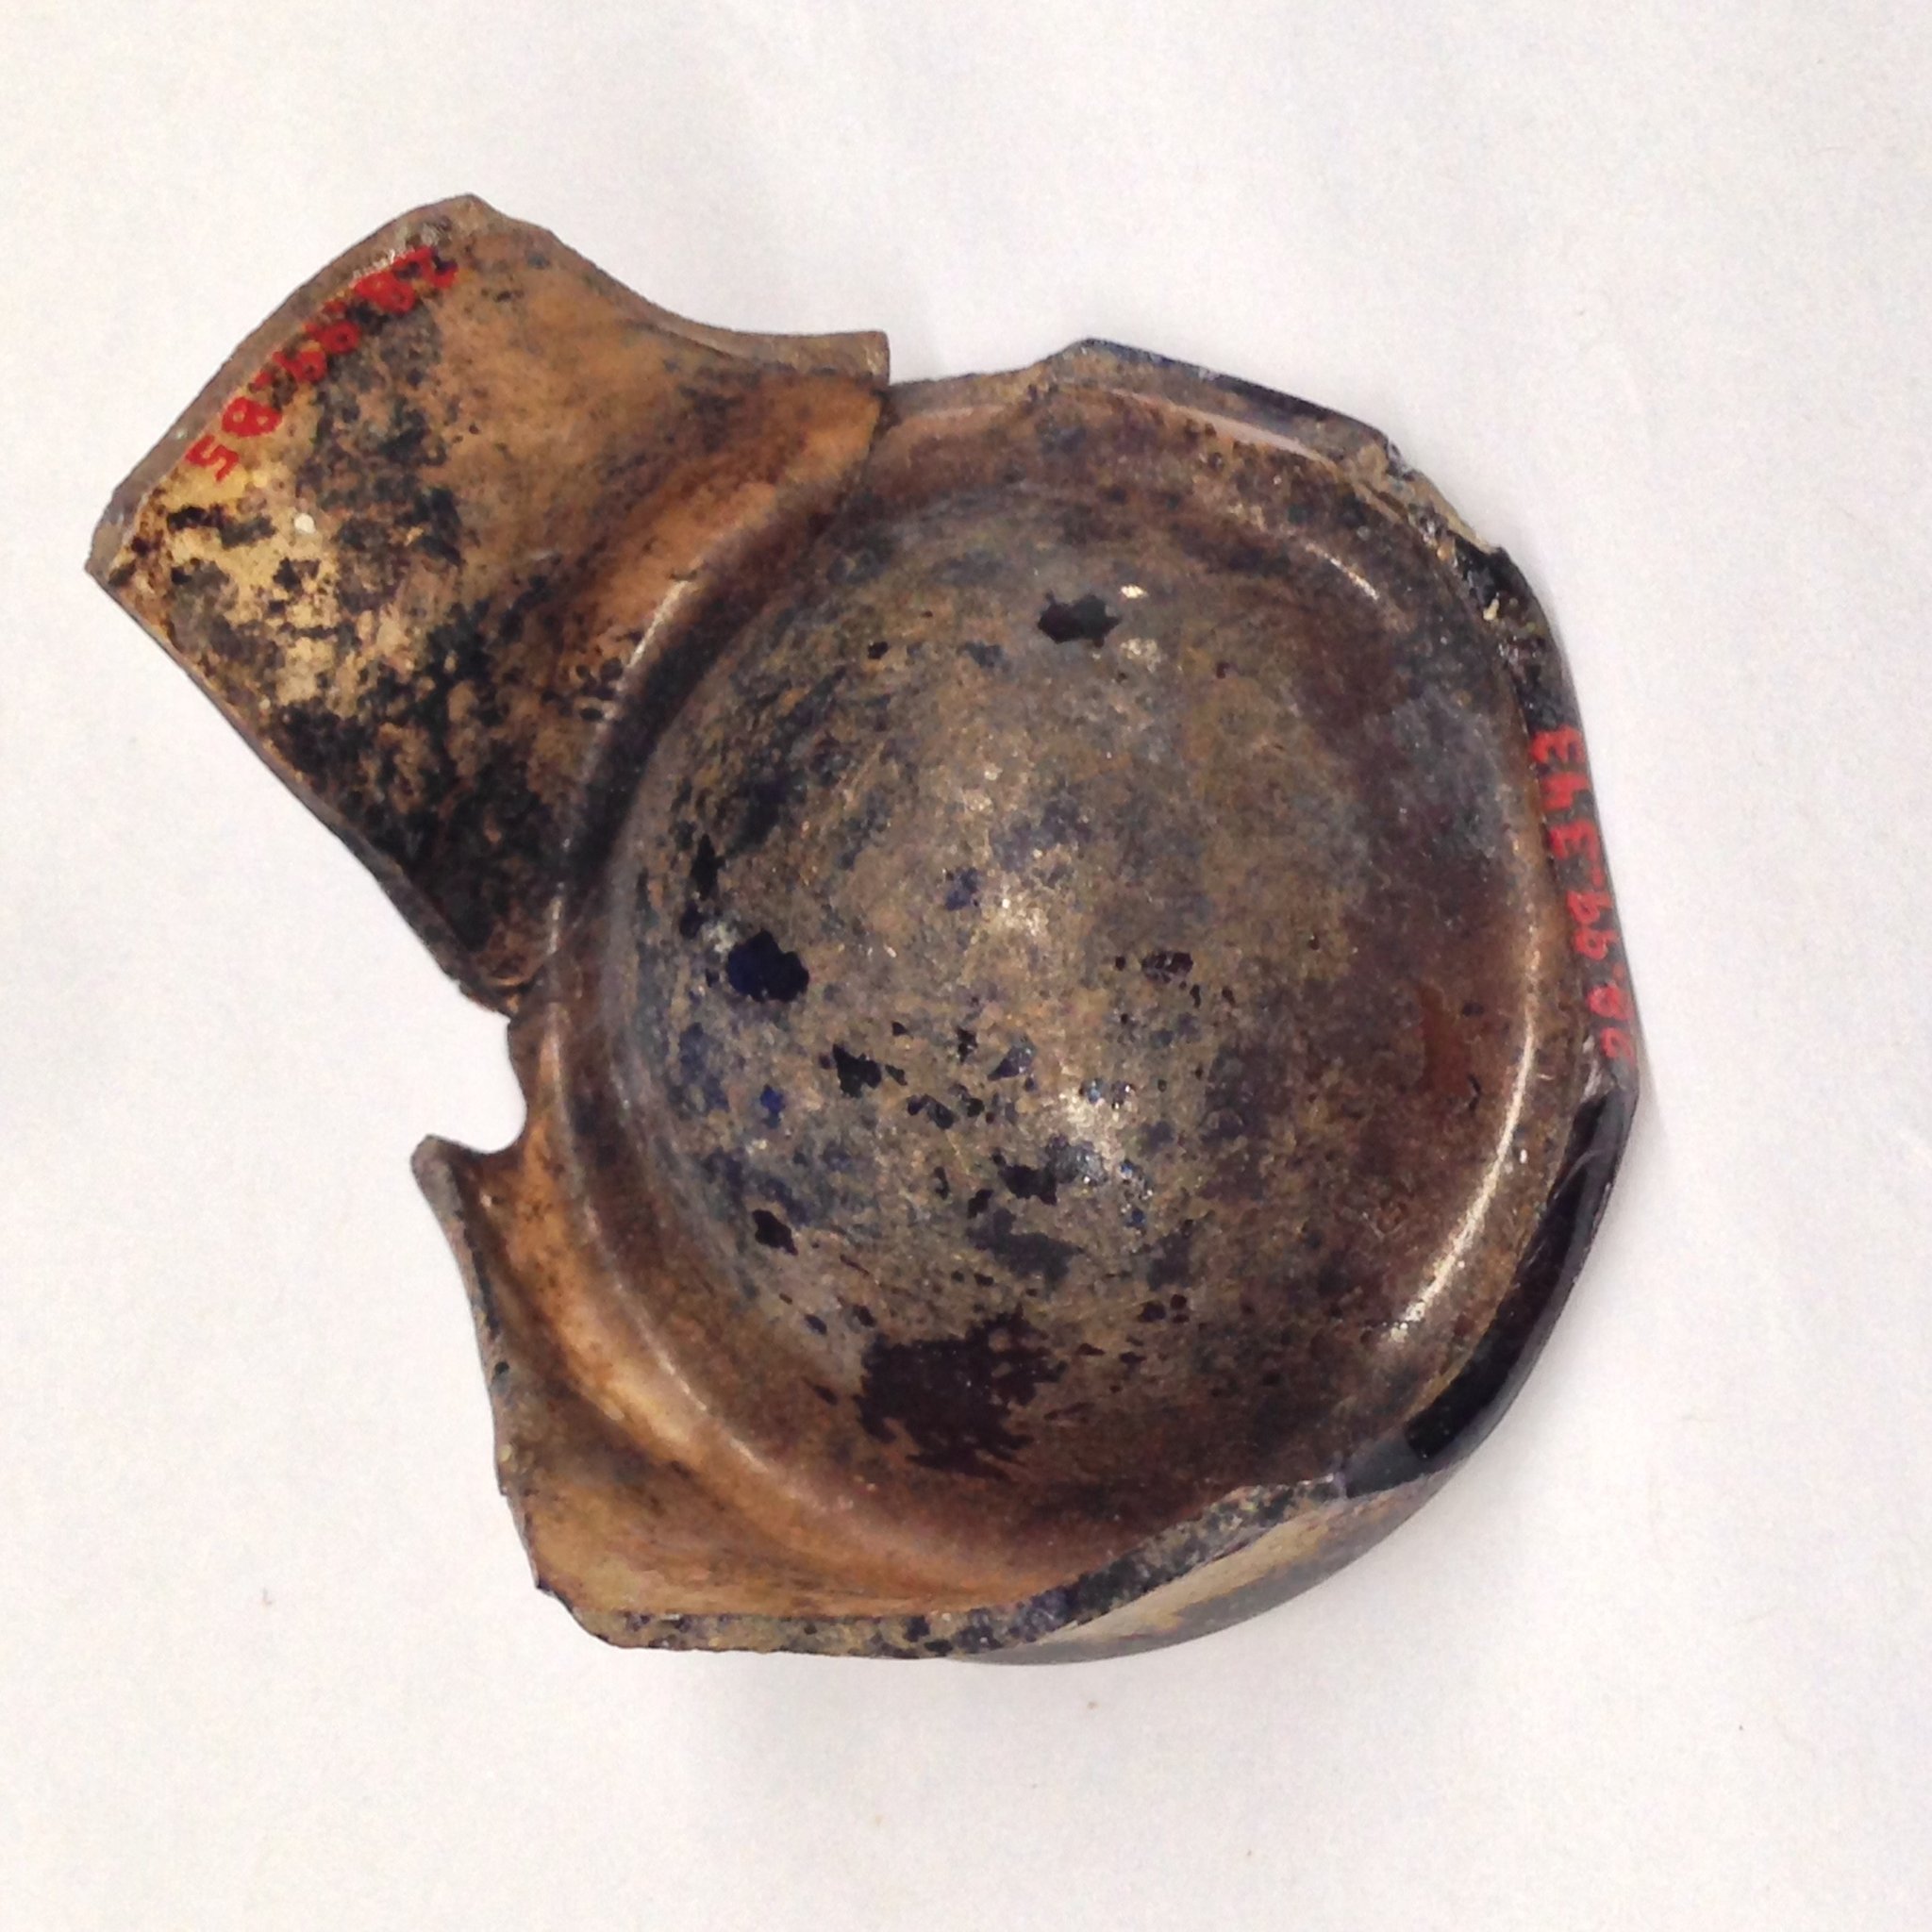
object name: fragment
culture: european or middle eastern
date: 1150-1250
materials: ceramic, glass